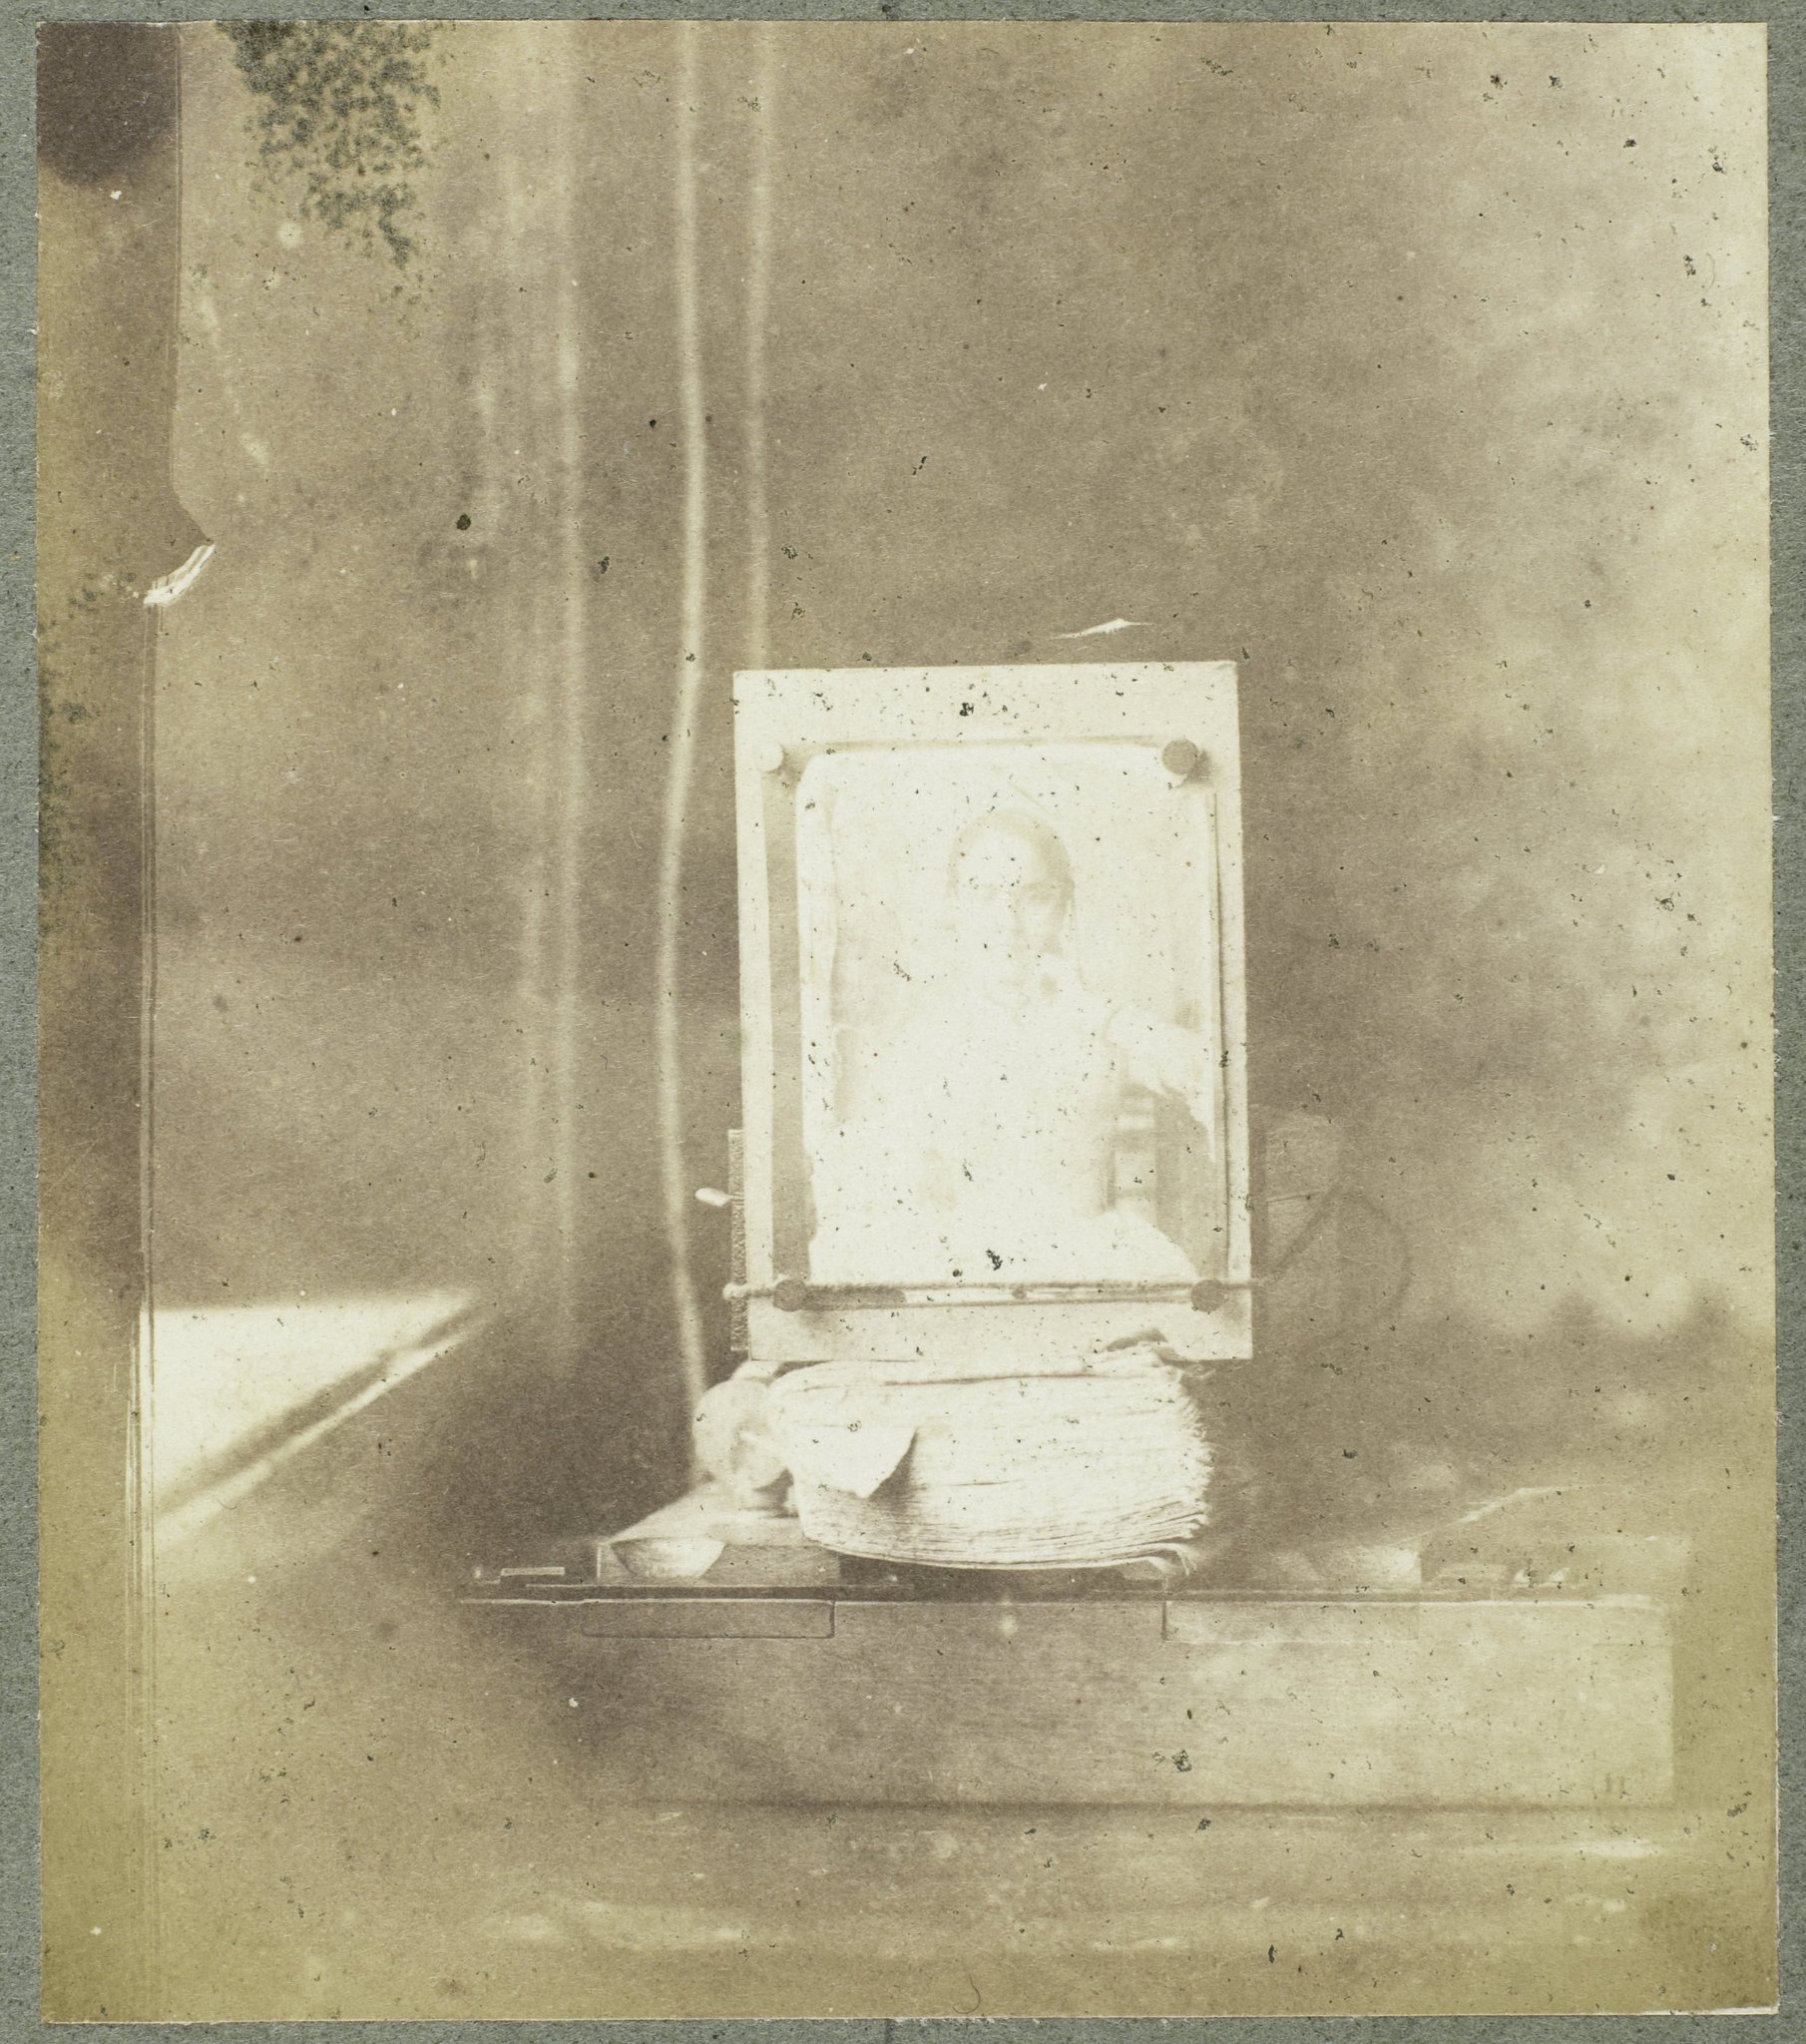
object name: photograph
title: Foto met daarop een portret van een meisje ingelijst op het bureau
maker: eduard isaac asser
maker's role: amateurfotograaf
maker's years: 1809-1894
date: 1845-1855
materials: cardboard, paper, photographic support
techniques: salted paper print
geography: amsterdam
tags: historical persons - bb - woman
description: zelfde meisje als op afbeelding RP-F-AB 12277-AF